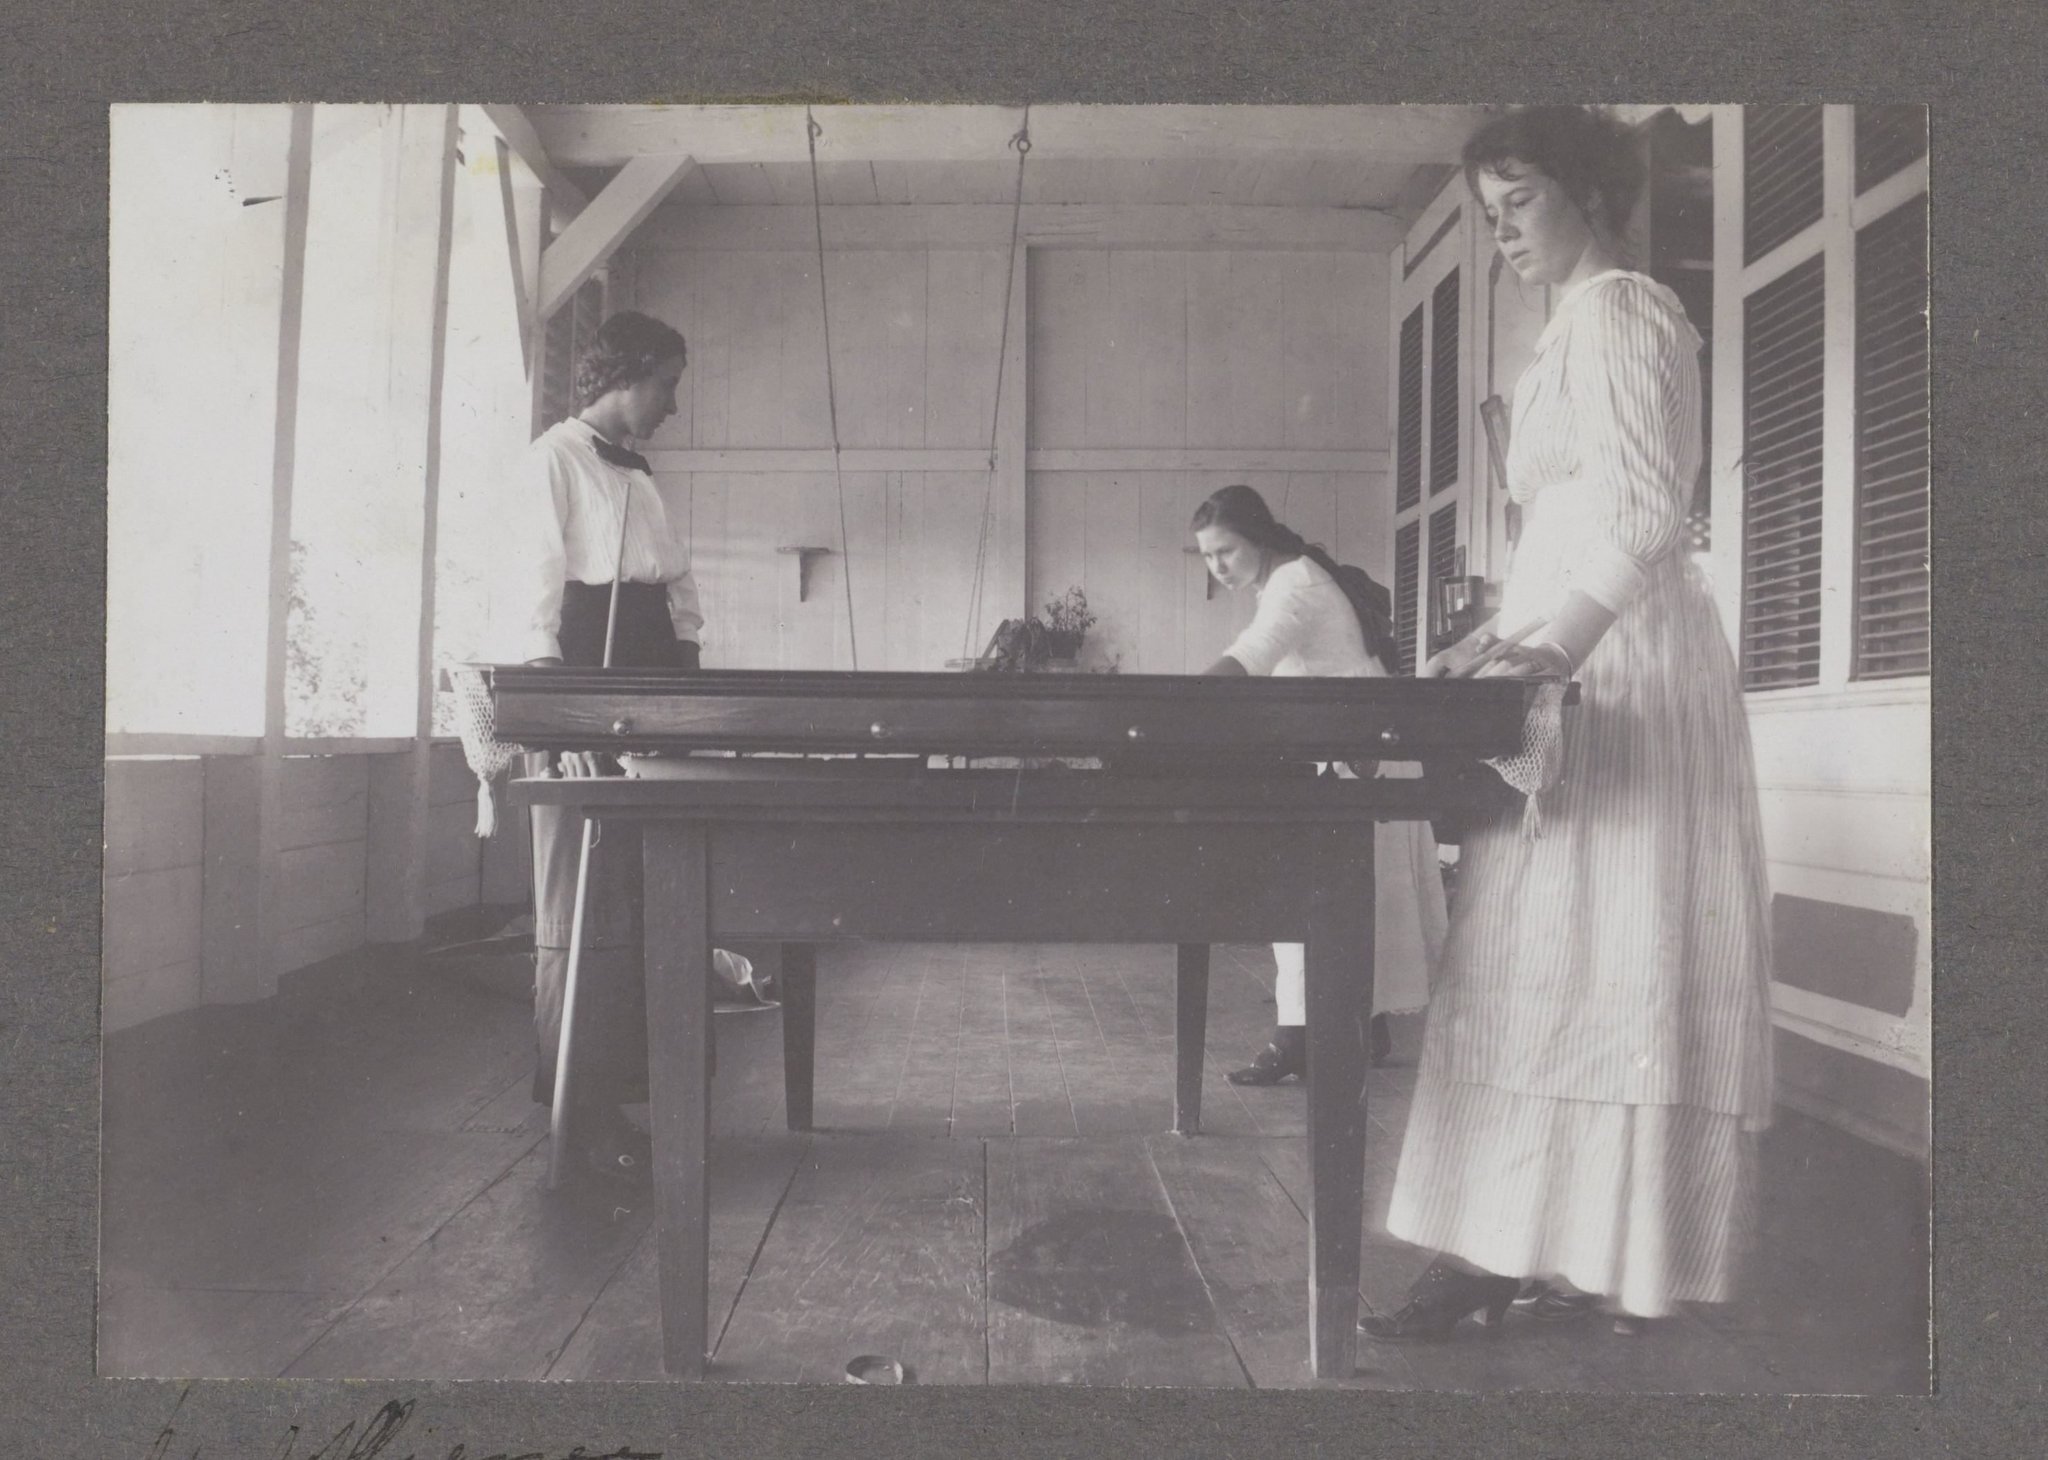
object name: photograph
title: Drie vrouwen aan het biljarten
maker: Anonymous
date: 1910-1914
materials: photographic support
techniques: photography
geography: suriname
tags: billiards, suriname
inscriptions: inscription: ‘Op Alliance’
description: Drie vrouwen aan het biljarten, op Plantage Alliance. Links Maria Gonggrijp. Onderdeel van een groep van elf albumbladen met familiefoto's van de familie Gonggrijp in Suriname, ca. 1912.